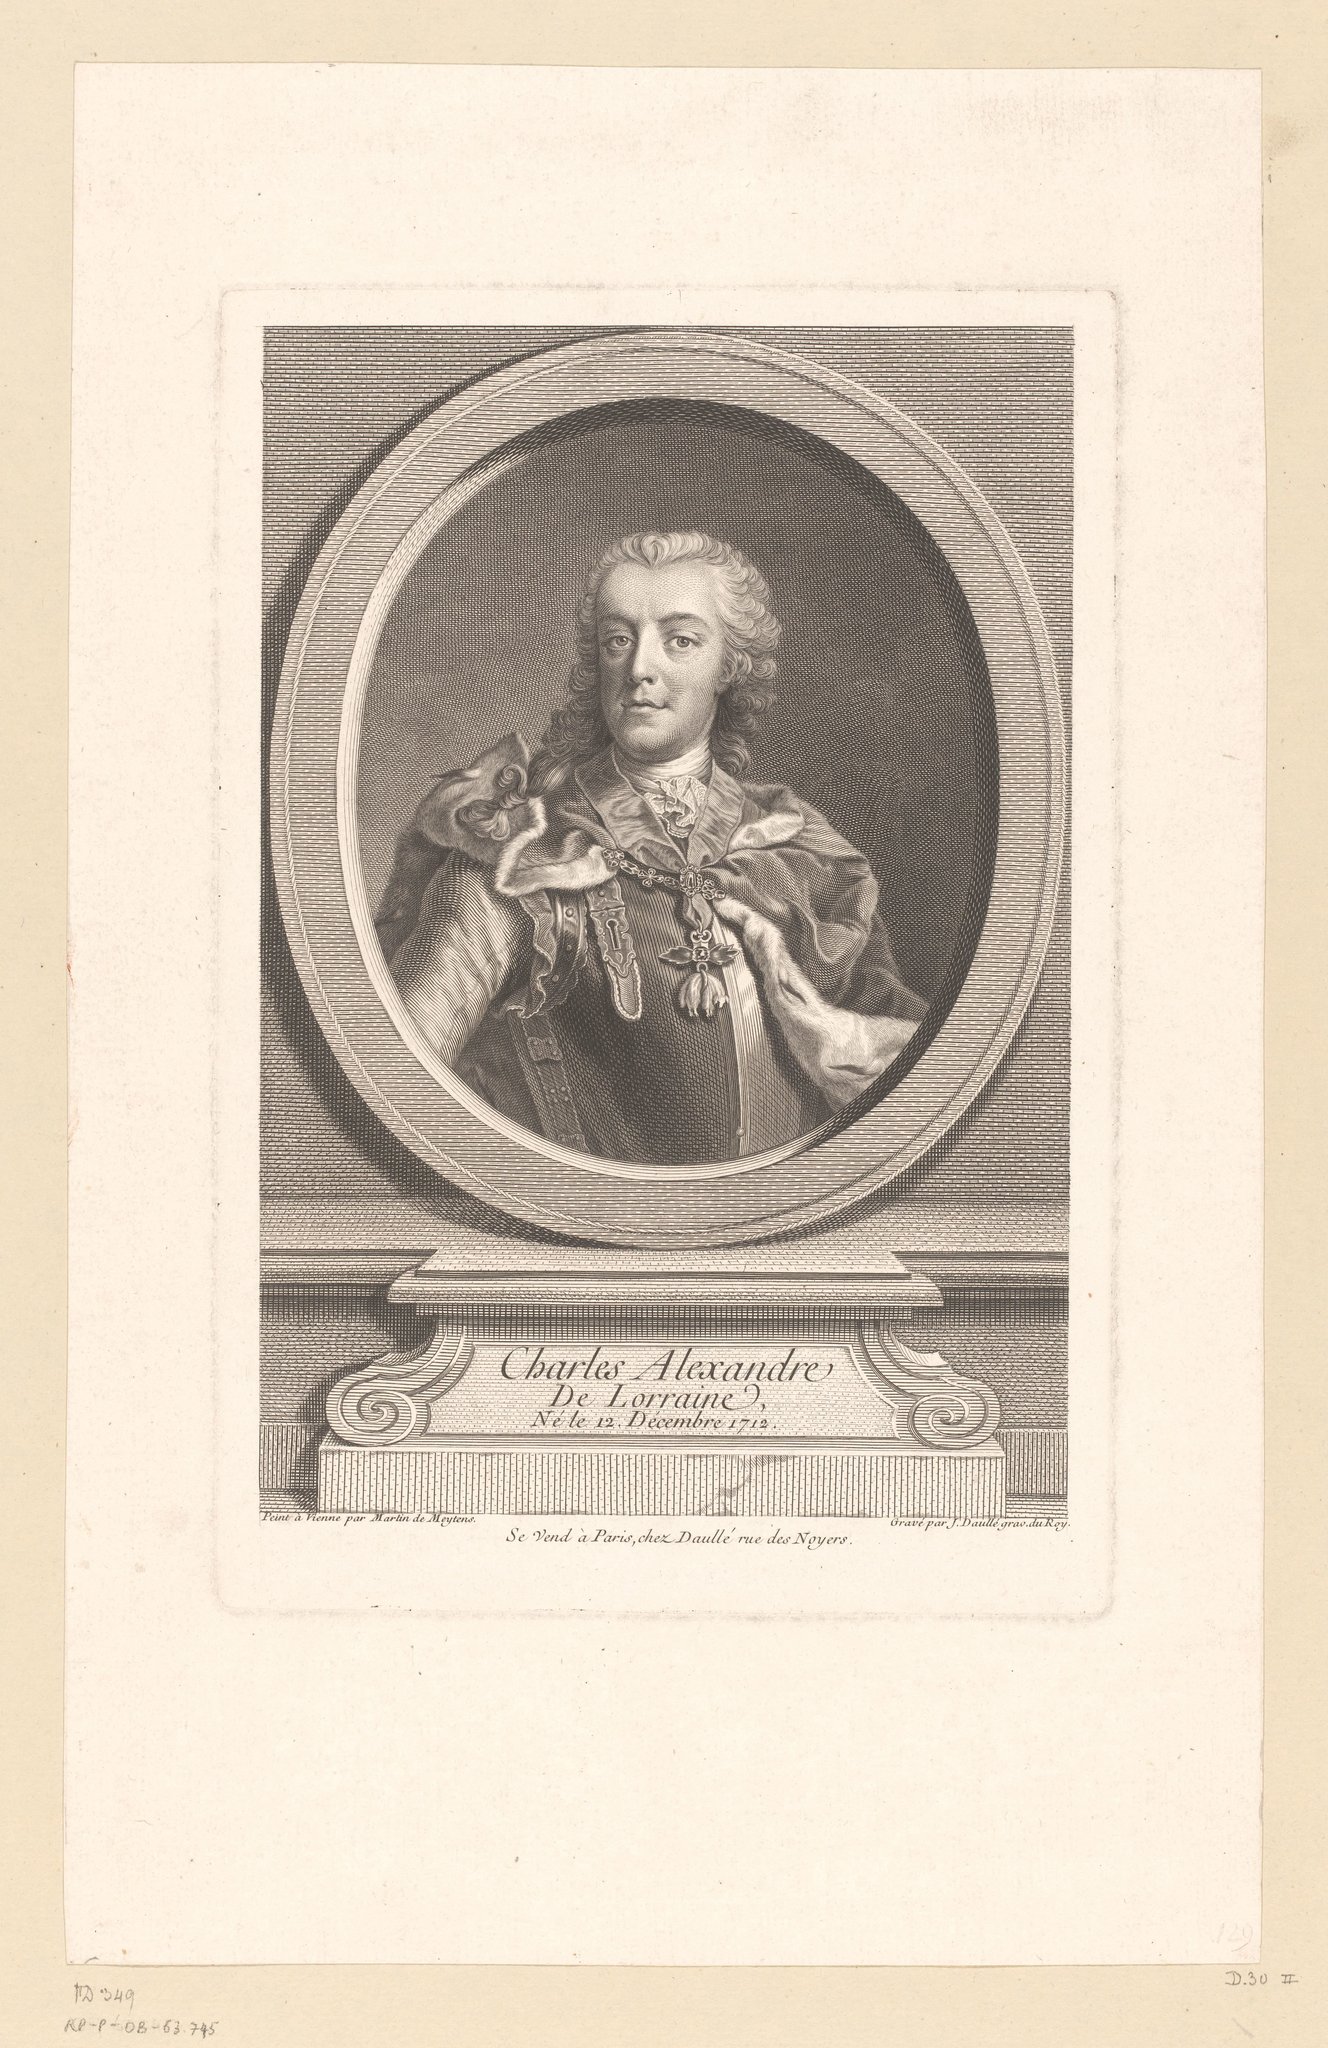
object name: print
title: Charles Alexandre De Lorraine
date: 1745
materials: paper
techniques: engraving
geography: paris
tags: karel alexander hertog van lotharingen, historical persons, ruler, sovereign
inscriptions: collector's mark: Lugt 240